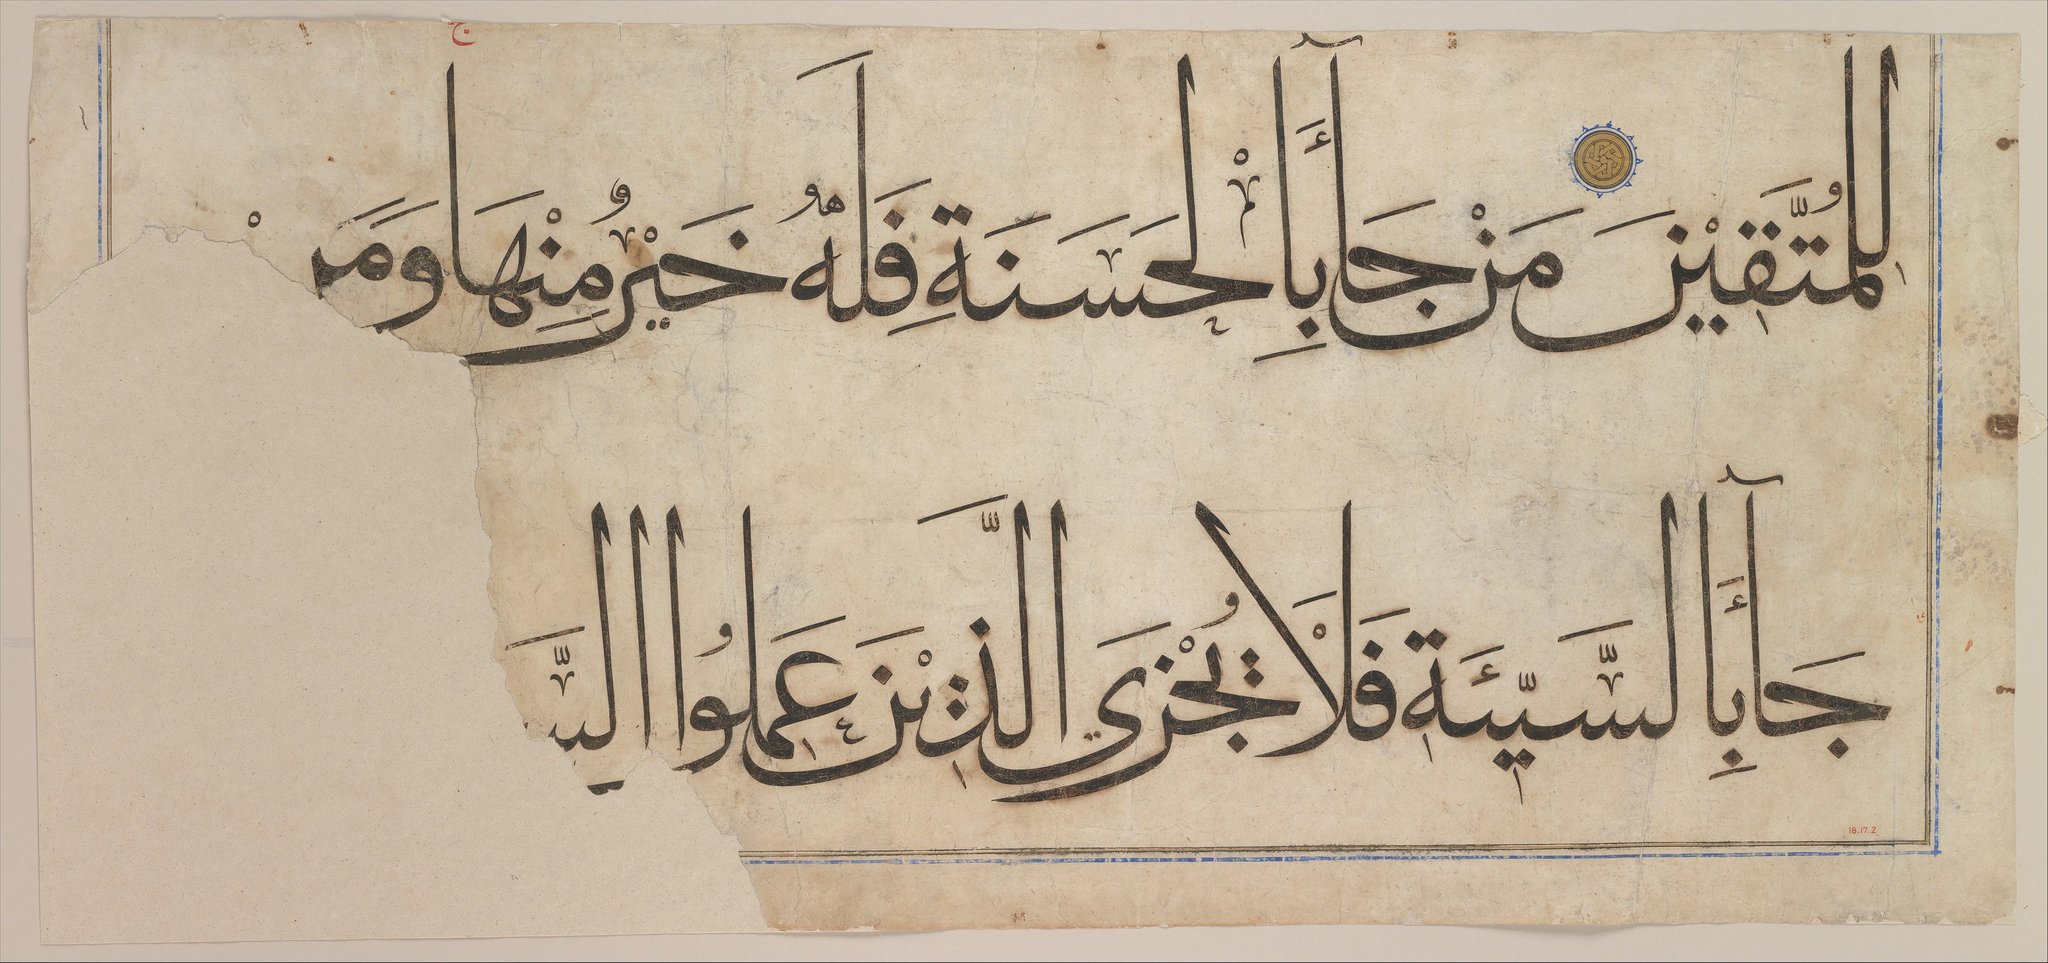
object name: section from a non illustrated manuscript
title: Section from the "Qur'an of `Umar Aqta'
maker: `umar aqta'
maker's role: calligrapher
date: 1367-1433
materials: gold, ink, paper, watercolor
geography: uzbekistan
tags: qur'an,calligraphy